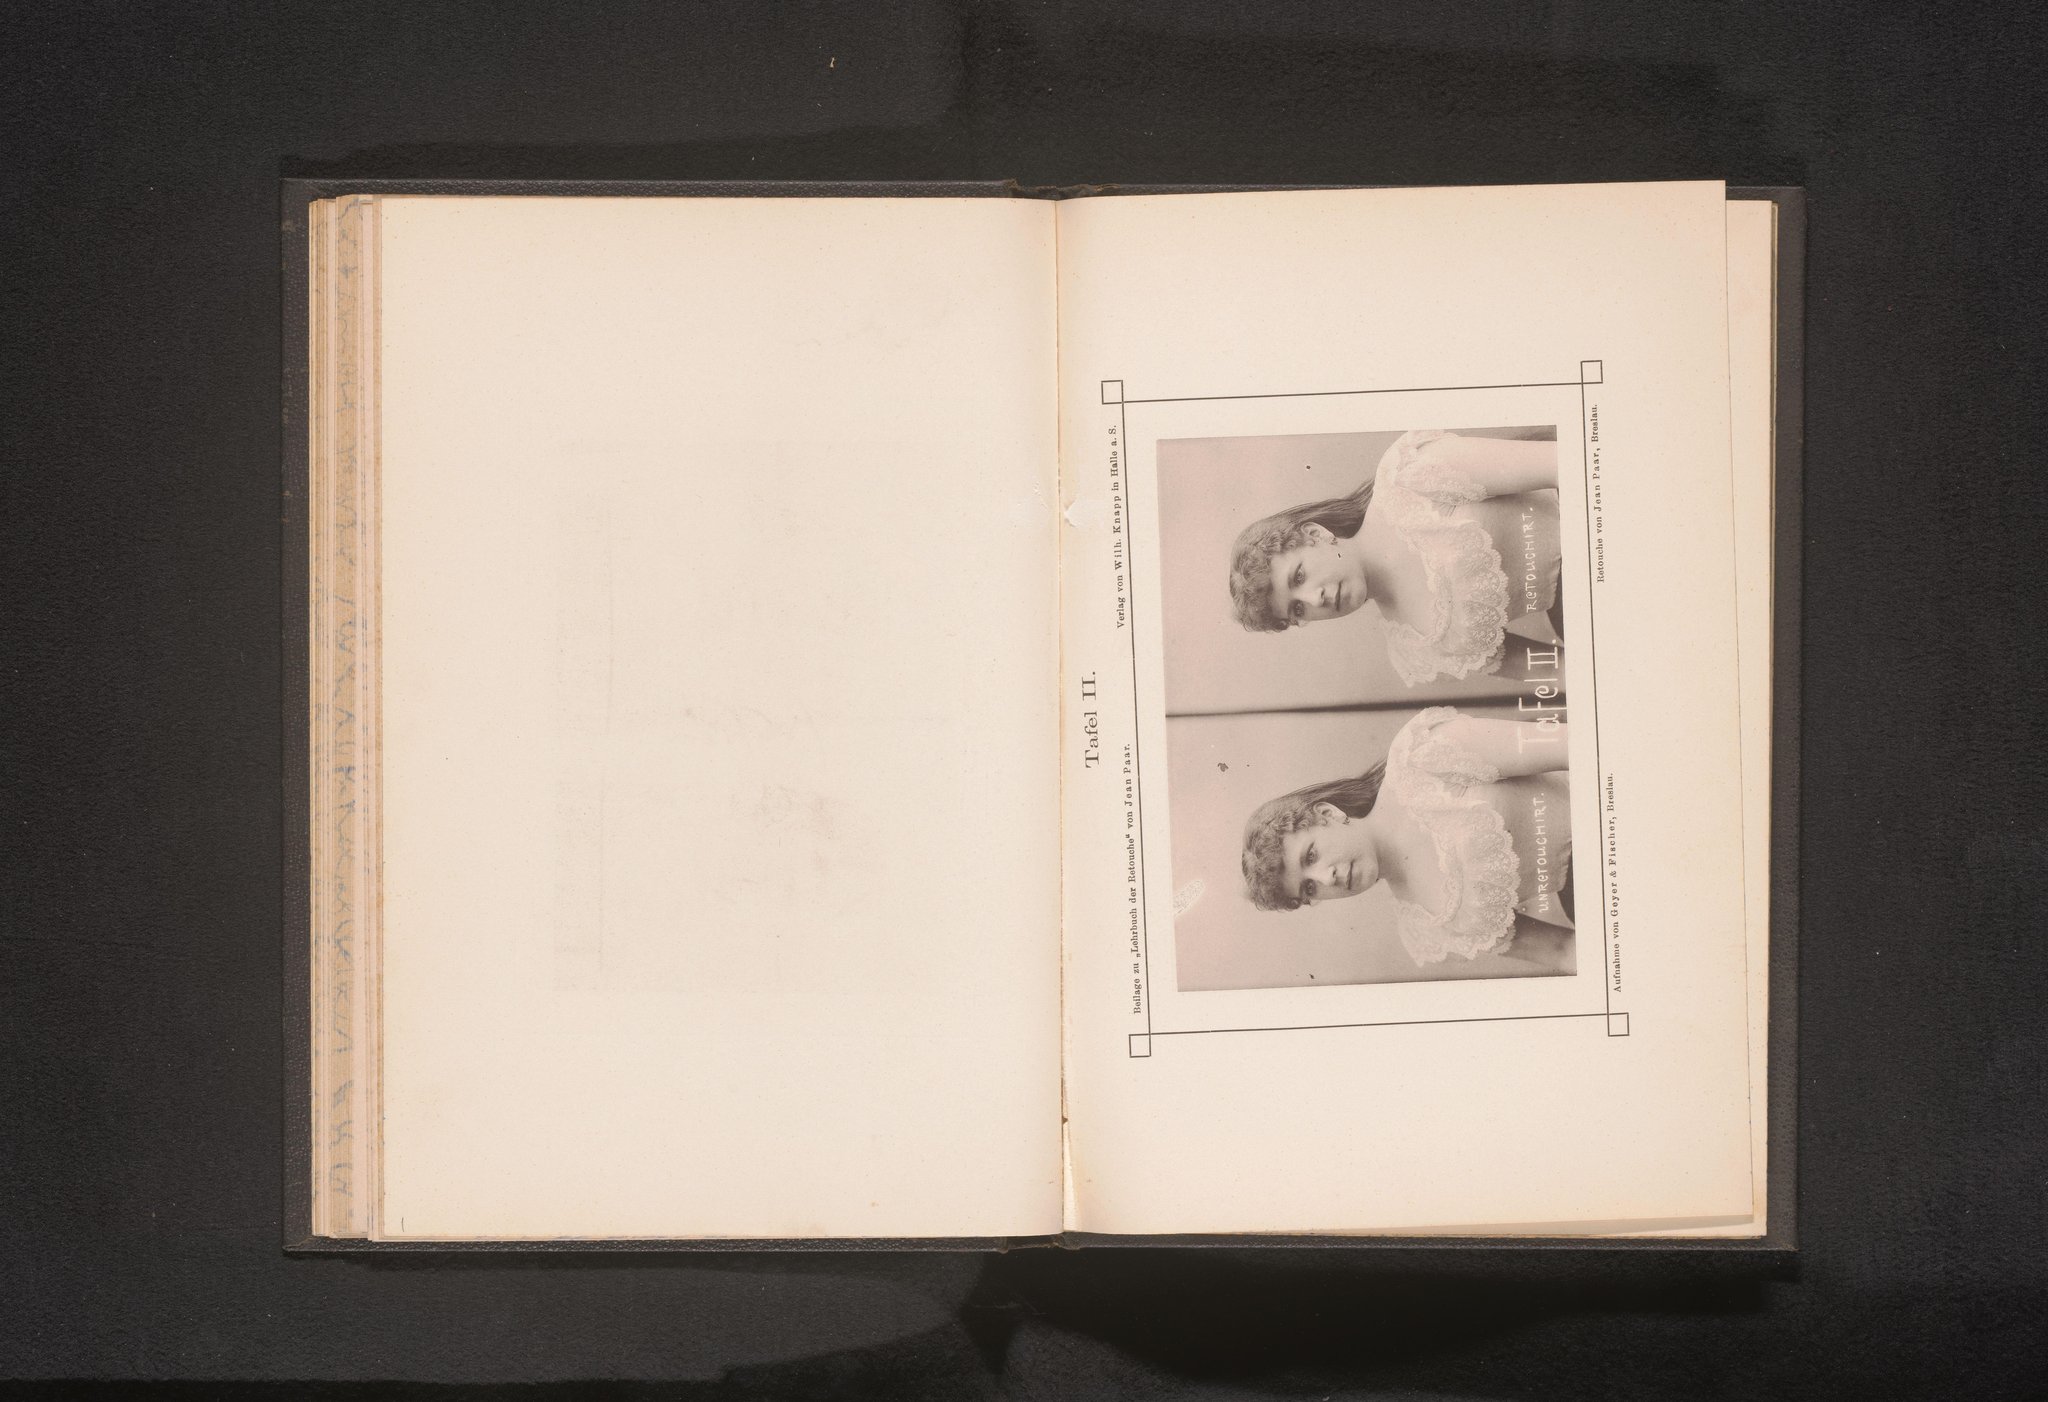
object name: photomechanical print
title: Twee portretten van een onbekende vrouw, met en zonder retouche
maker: Anonymous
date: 1880-1890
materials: paper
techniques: photograph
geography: breslau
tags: adult woman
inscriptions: inscription: ‘unretouchirt retouchirt’, number: ‘Tafel II.’